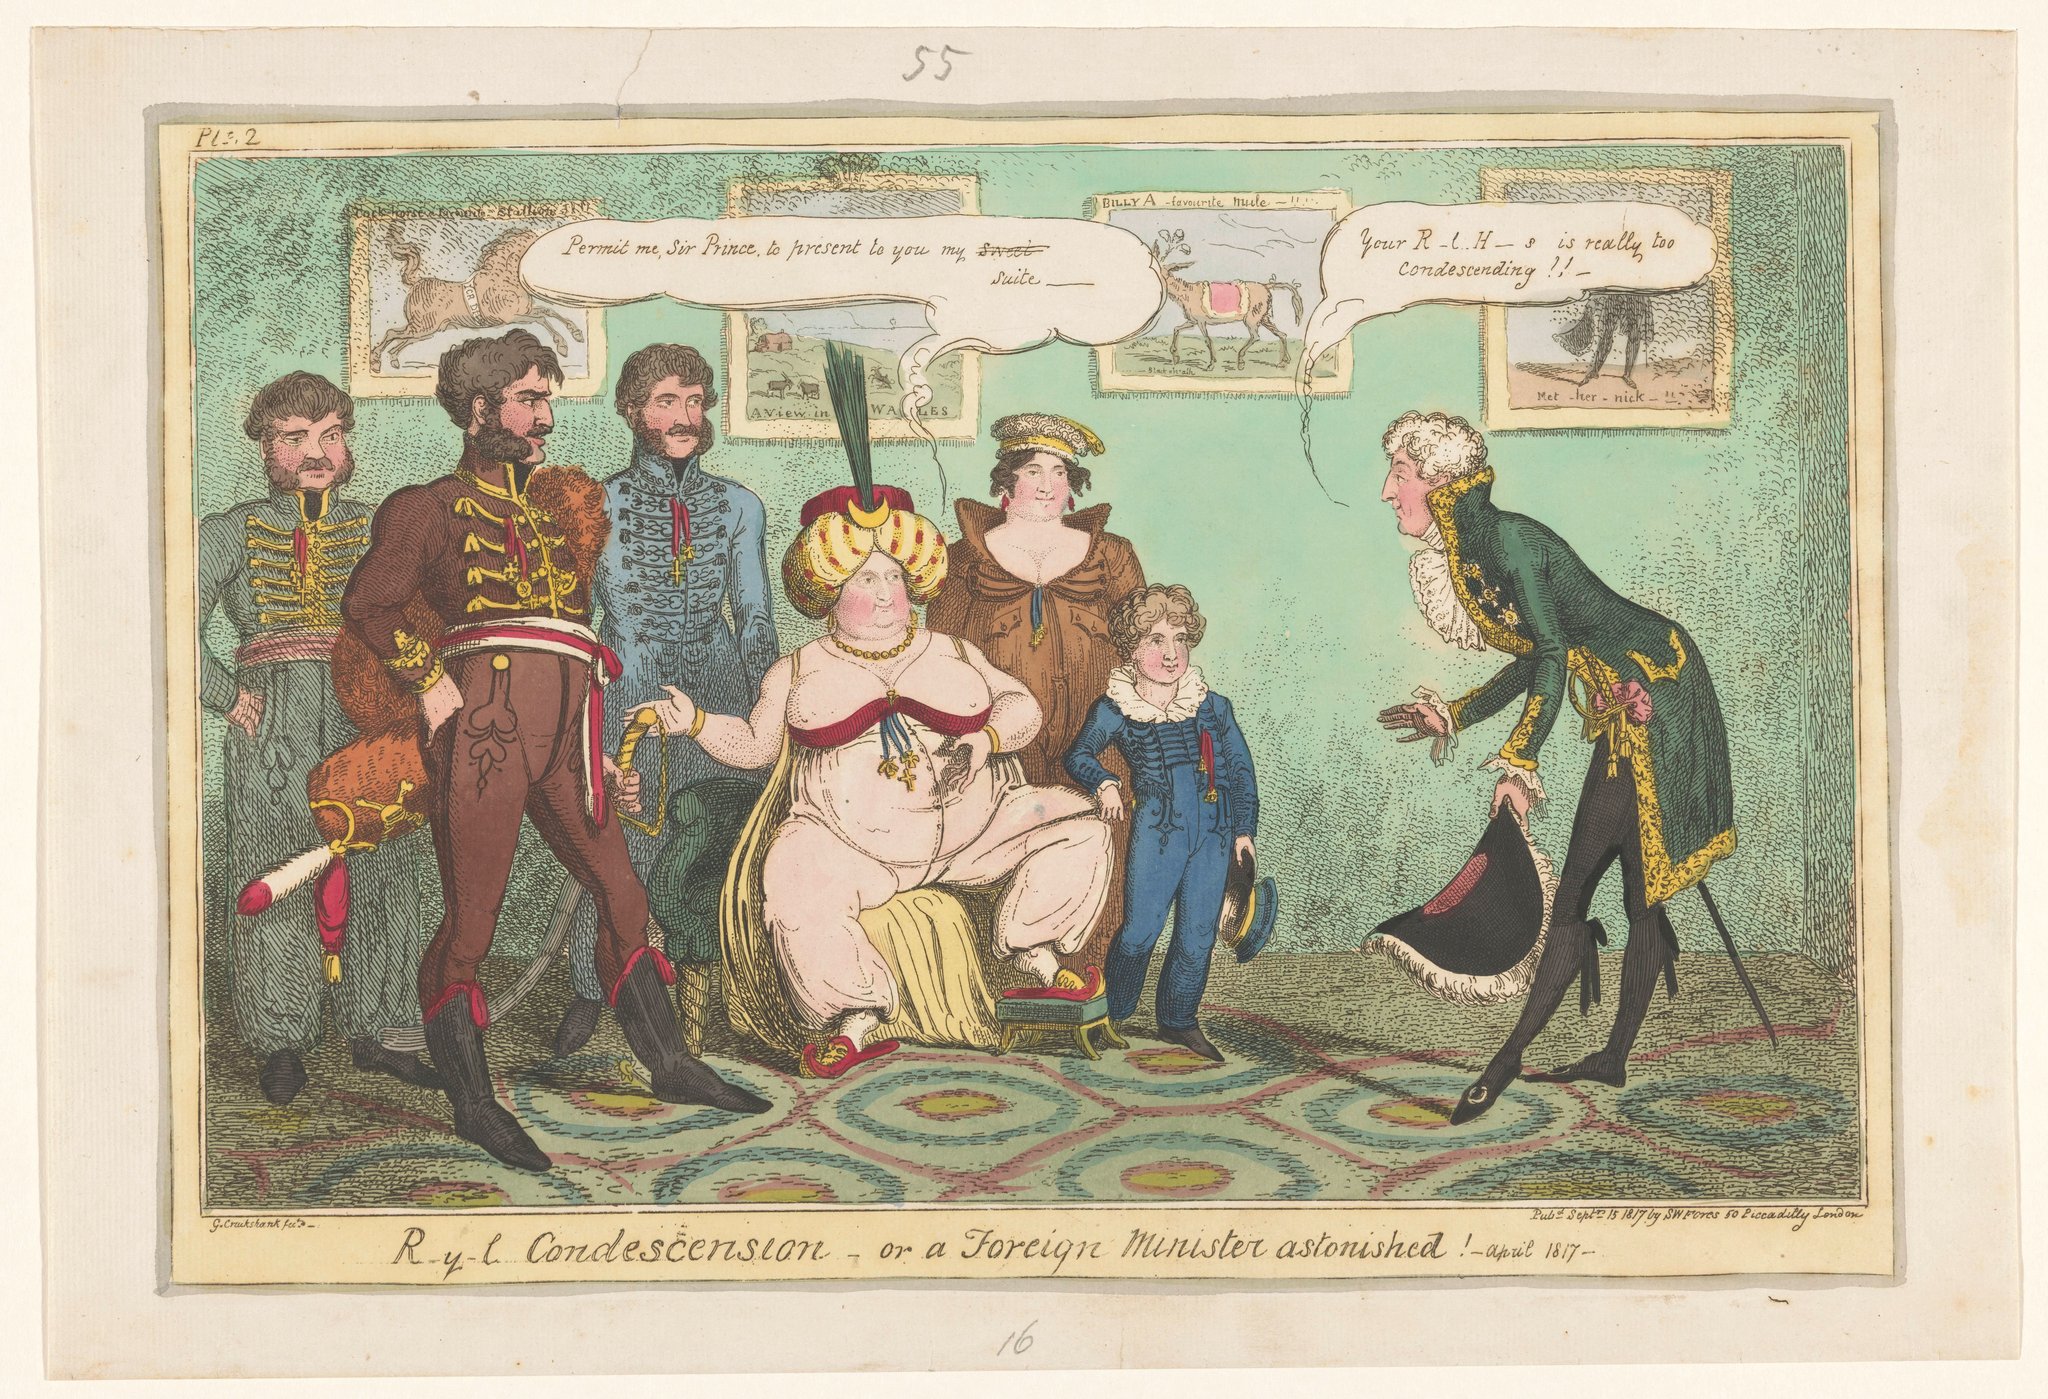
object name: print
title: R-y-l Condescension or a Foreign Minister astonished!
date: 1817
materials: paper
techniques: etching, hand coloring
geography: england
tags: vienna, asiatic races and peoples: turks (+ costume), political caricatures and satires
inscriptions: collector's mark: Lugt 2760, collector's mark: Lugt 2228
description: Spotprent op prinses Caroline van Brunswijk, 1817. De forse prinses met uitpuilende boezem voorgesteld als een Turkse sultan, met tulband met pluim. Zij stelt minister Klemens von Metternich voor aan haar gevolg, waaronder Bartolommeo Bergami (haar minnaar).